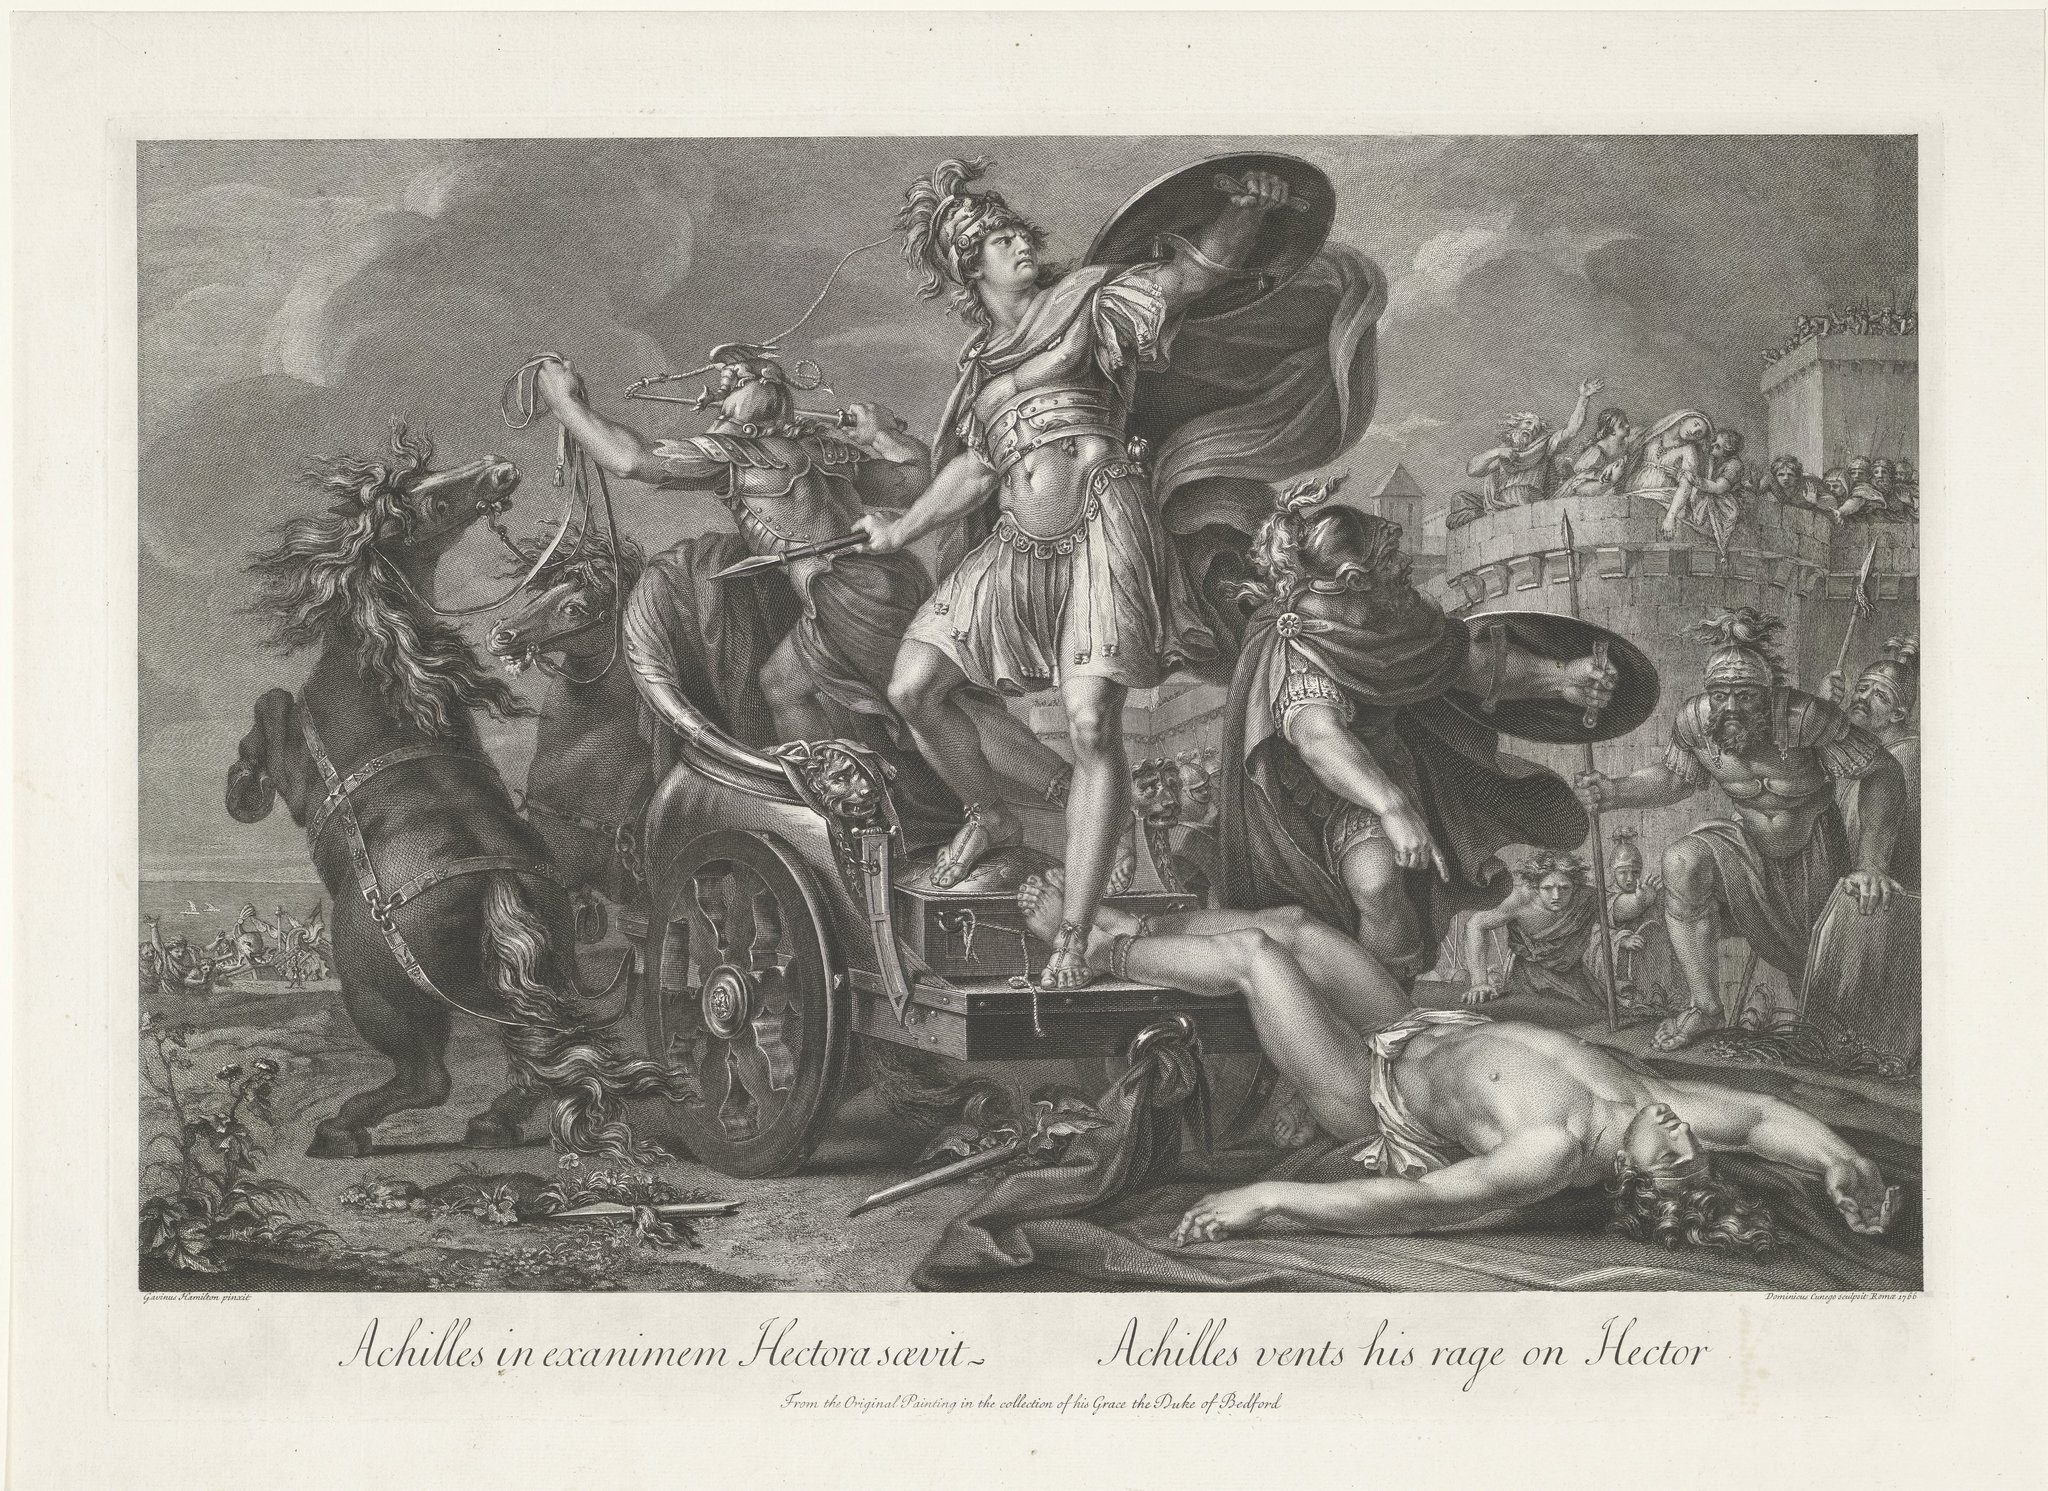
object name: print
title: Achilles sleept het lijk van Hector achter zijn wagen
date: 1766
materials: paper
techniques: engraving, etching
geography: rome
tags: achilles pursues hector around the wall of the city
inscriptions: collector's mark: Lugt 2165, collector's mark: Lugt 12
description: Achilles rijdt triomfant op zijn strijdwagen rond de stadsmuur van Troje en sleept het lijk van Hector vernederend achter de wagen aan.